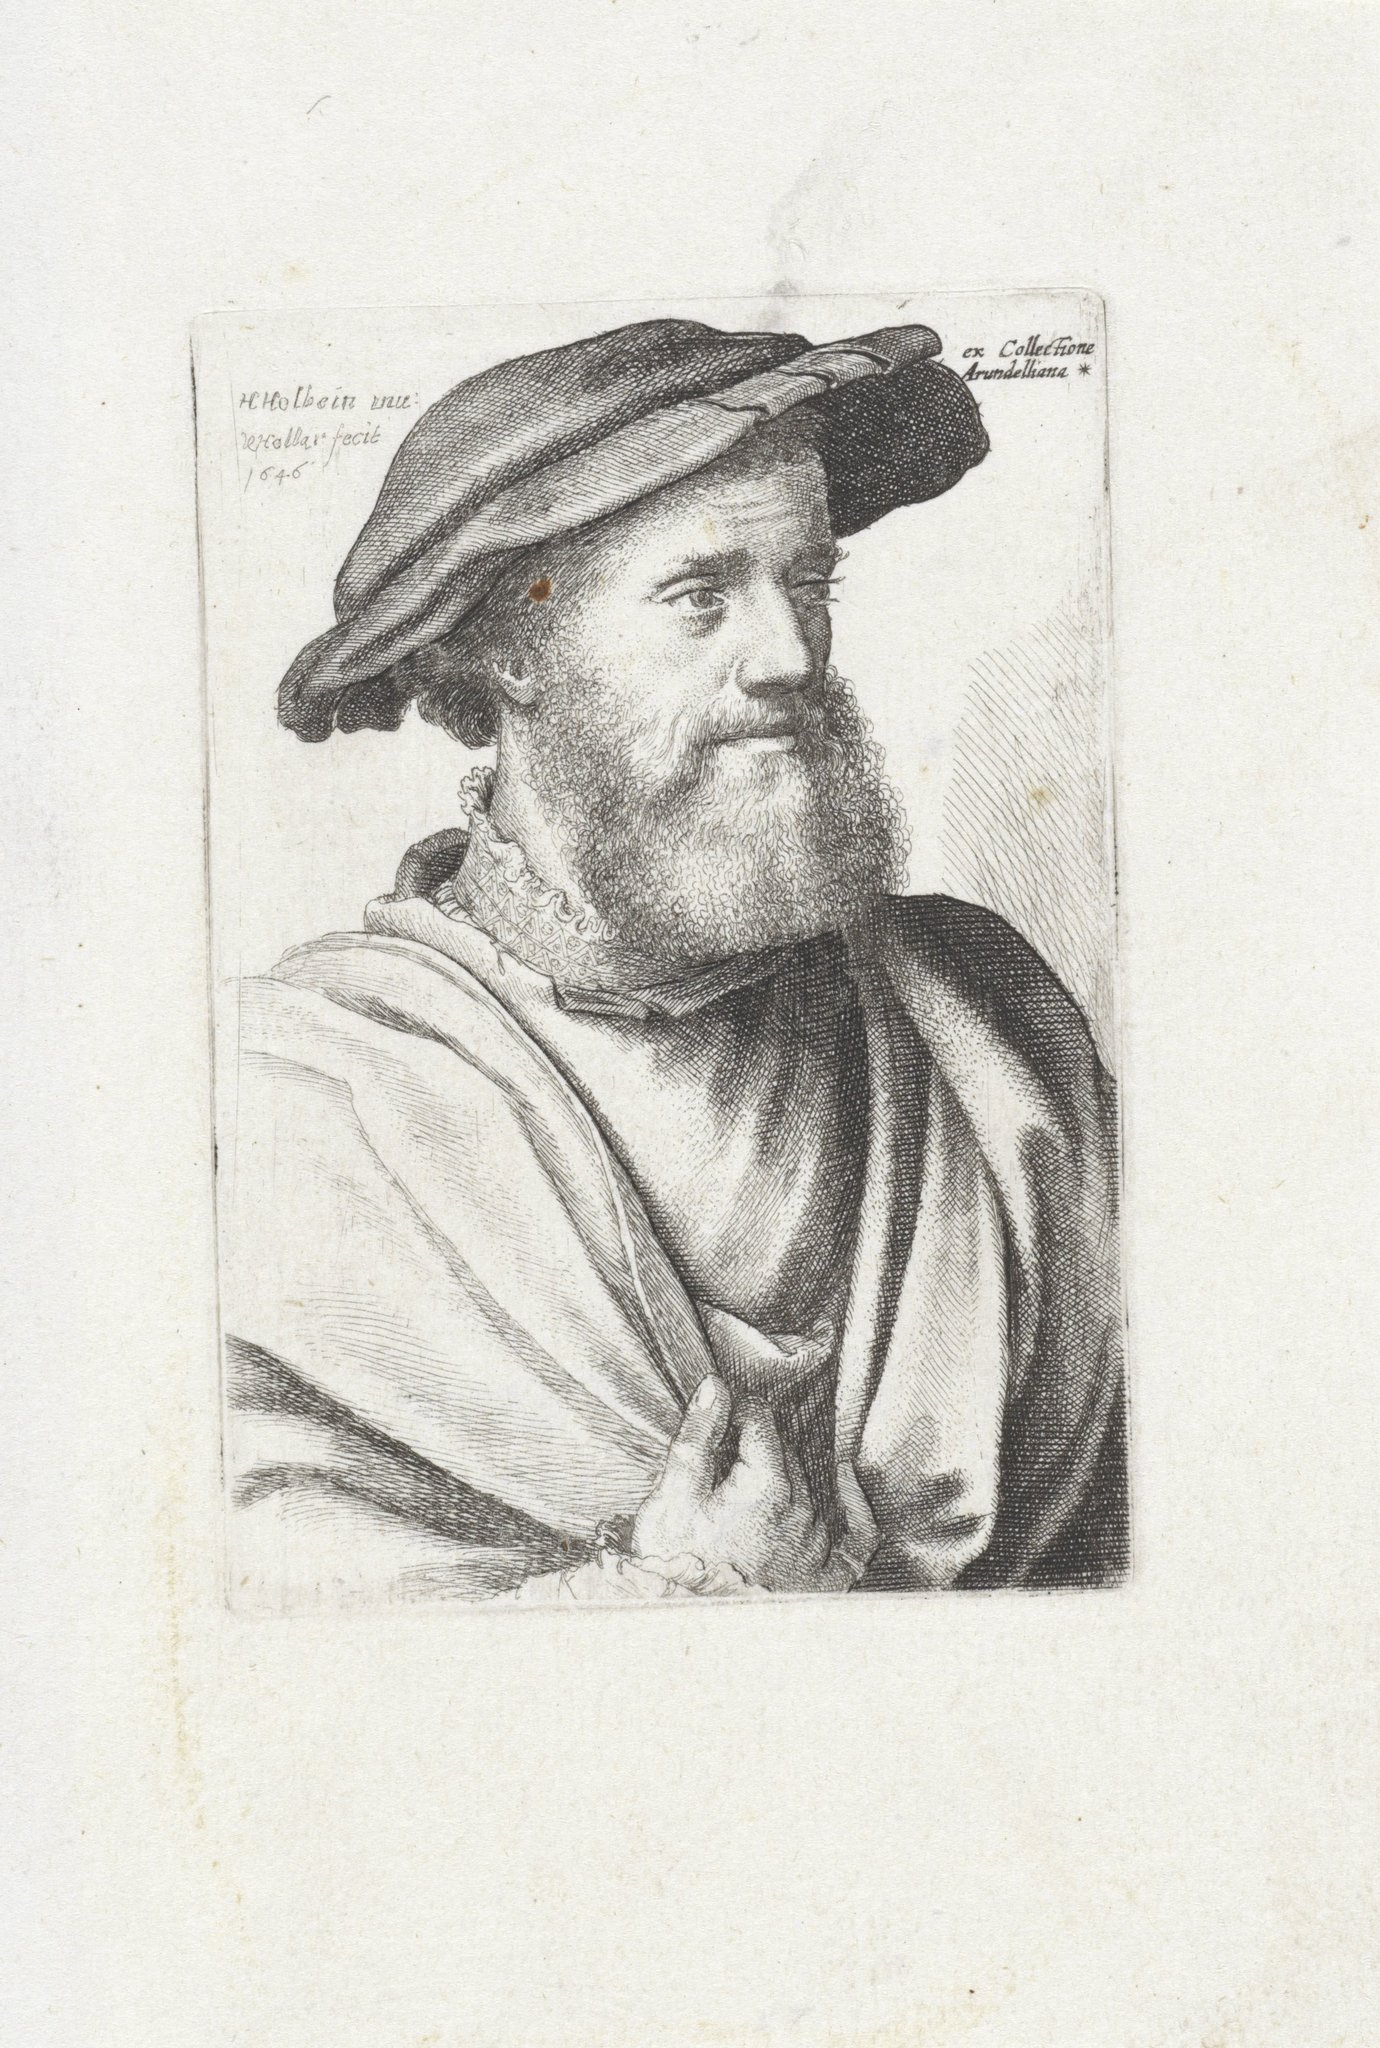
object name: print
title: Portret van Hans Holbein de Jonge (?)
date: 1646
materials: paper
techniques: engraving, etching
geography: antwerp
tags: london, painter, draughtsman, hans holbein (ii), head-gear (bonnet) (+ men's clothes), anonymous historical person portrayed alone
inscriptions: collector's mark: Lugt 2228